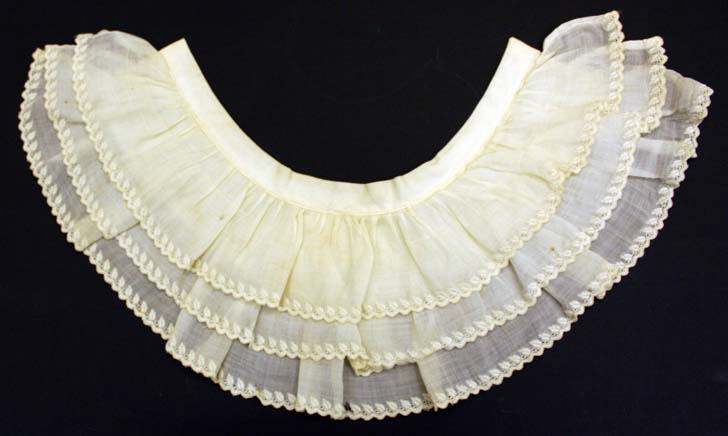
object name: collar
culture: american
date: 1700-1941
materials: cotton